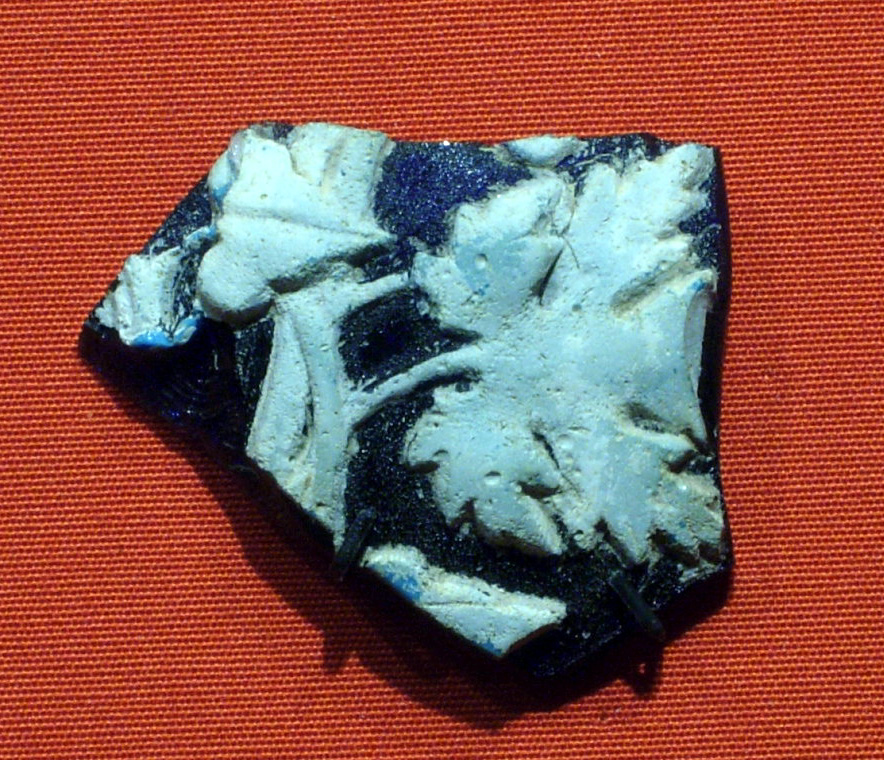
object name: vase fragment skyphos, cameo, ivy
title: Cameo fragment with ivy and vine leaves from a skyphos (footed wine cup)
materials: glass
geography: egypt or italy